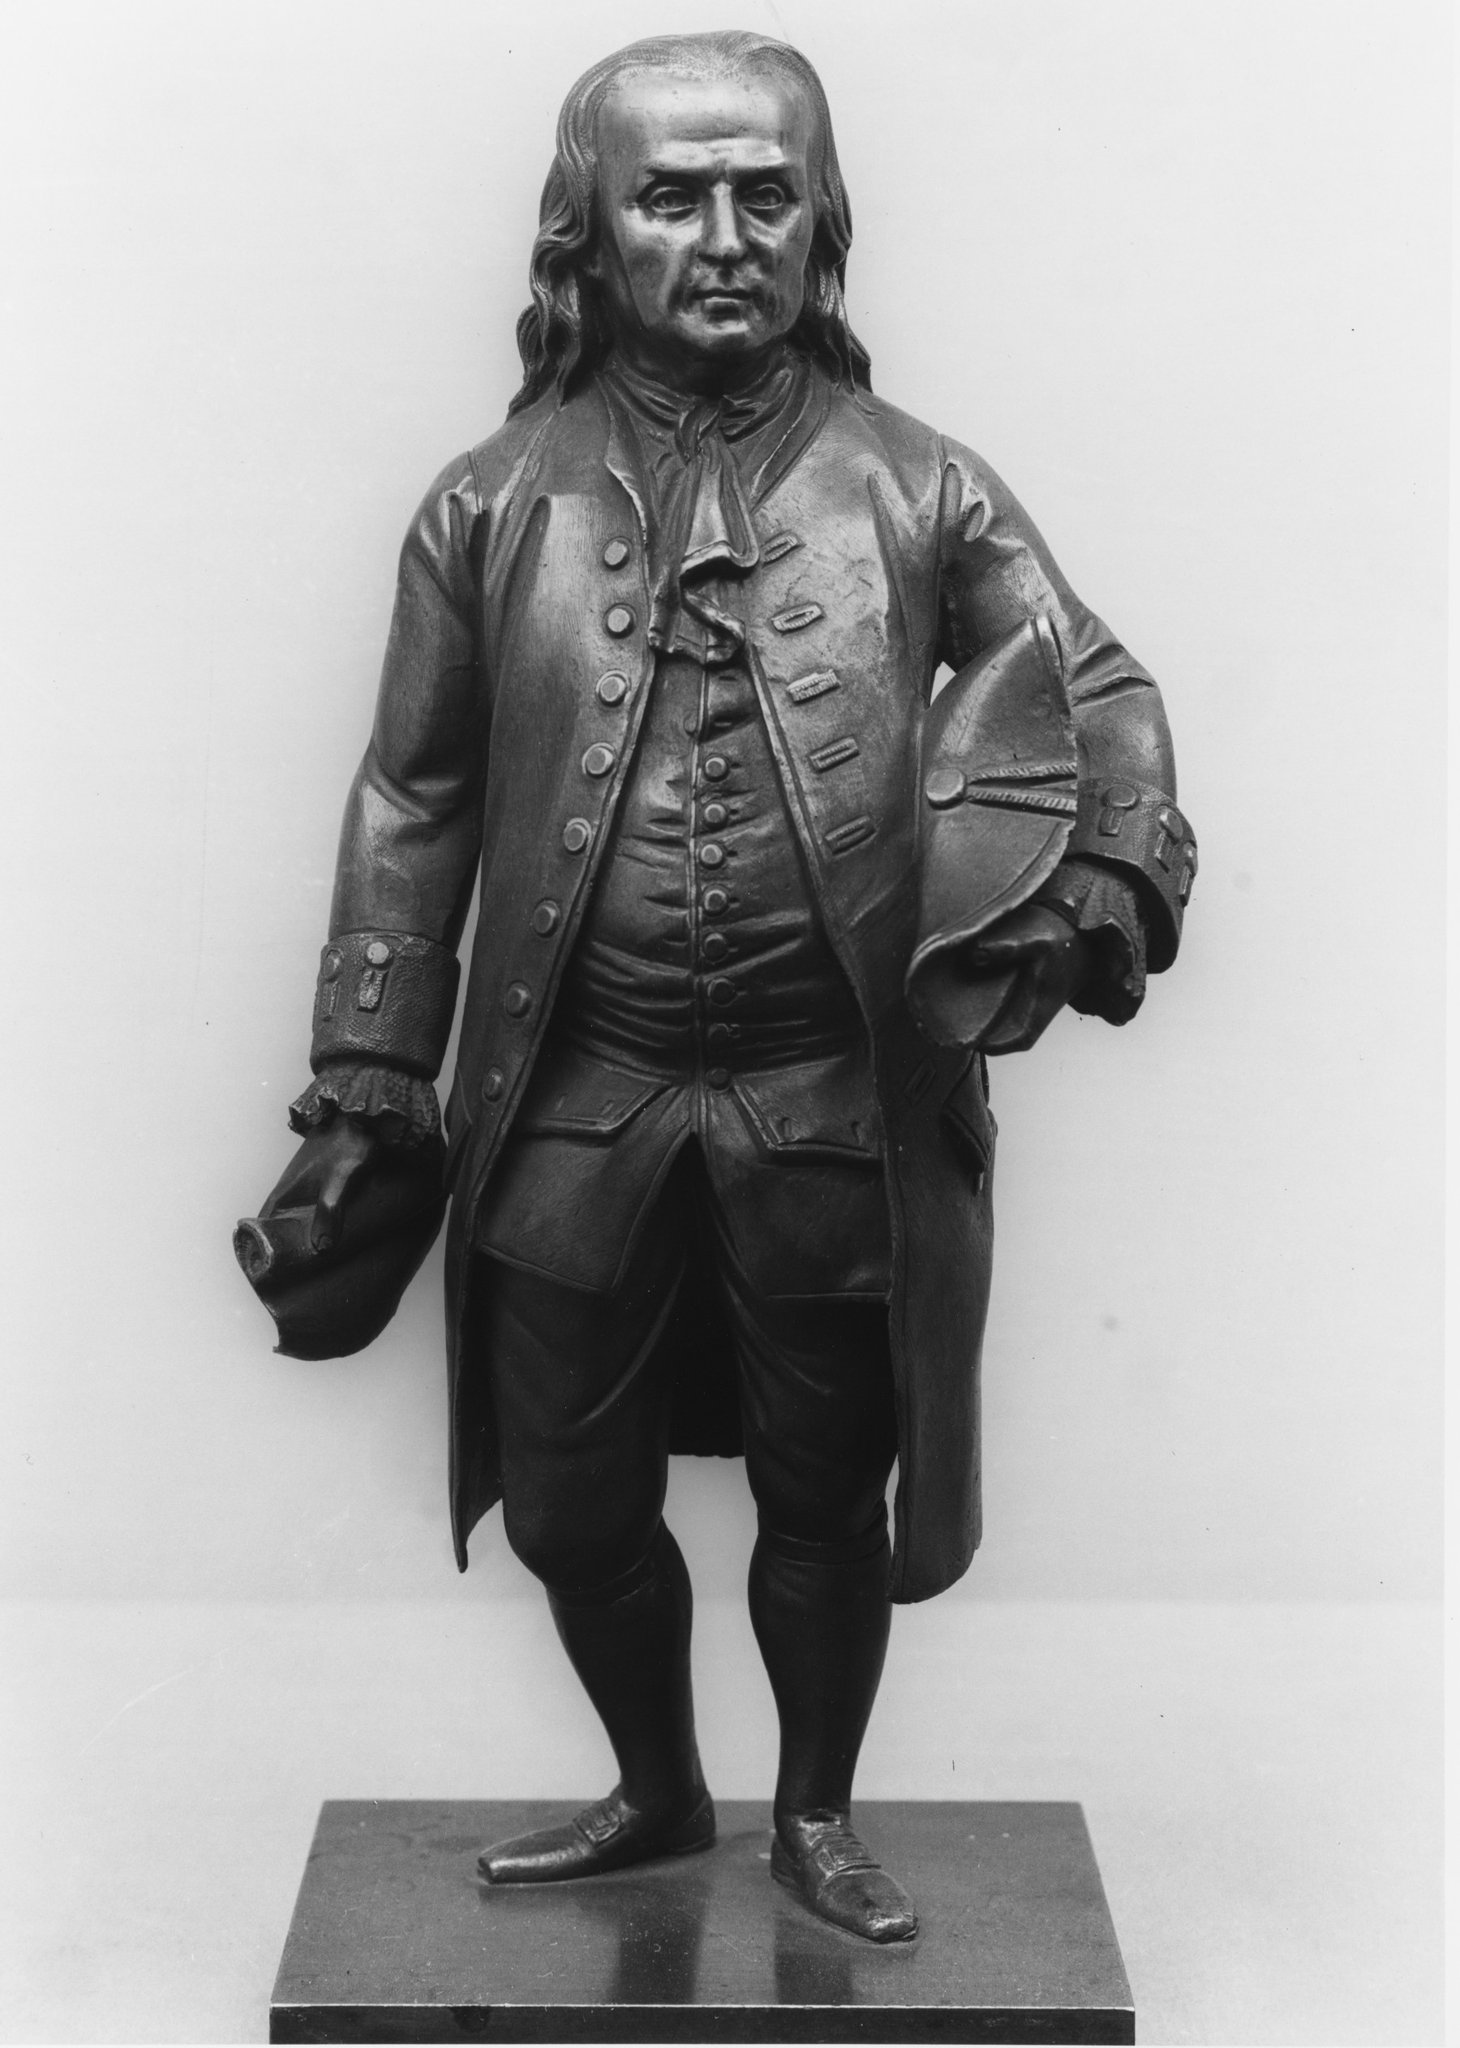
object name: statuette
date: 1800-1883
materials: bronze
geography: germany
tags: benjamin franklin,men,profiles